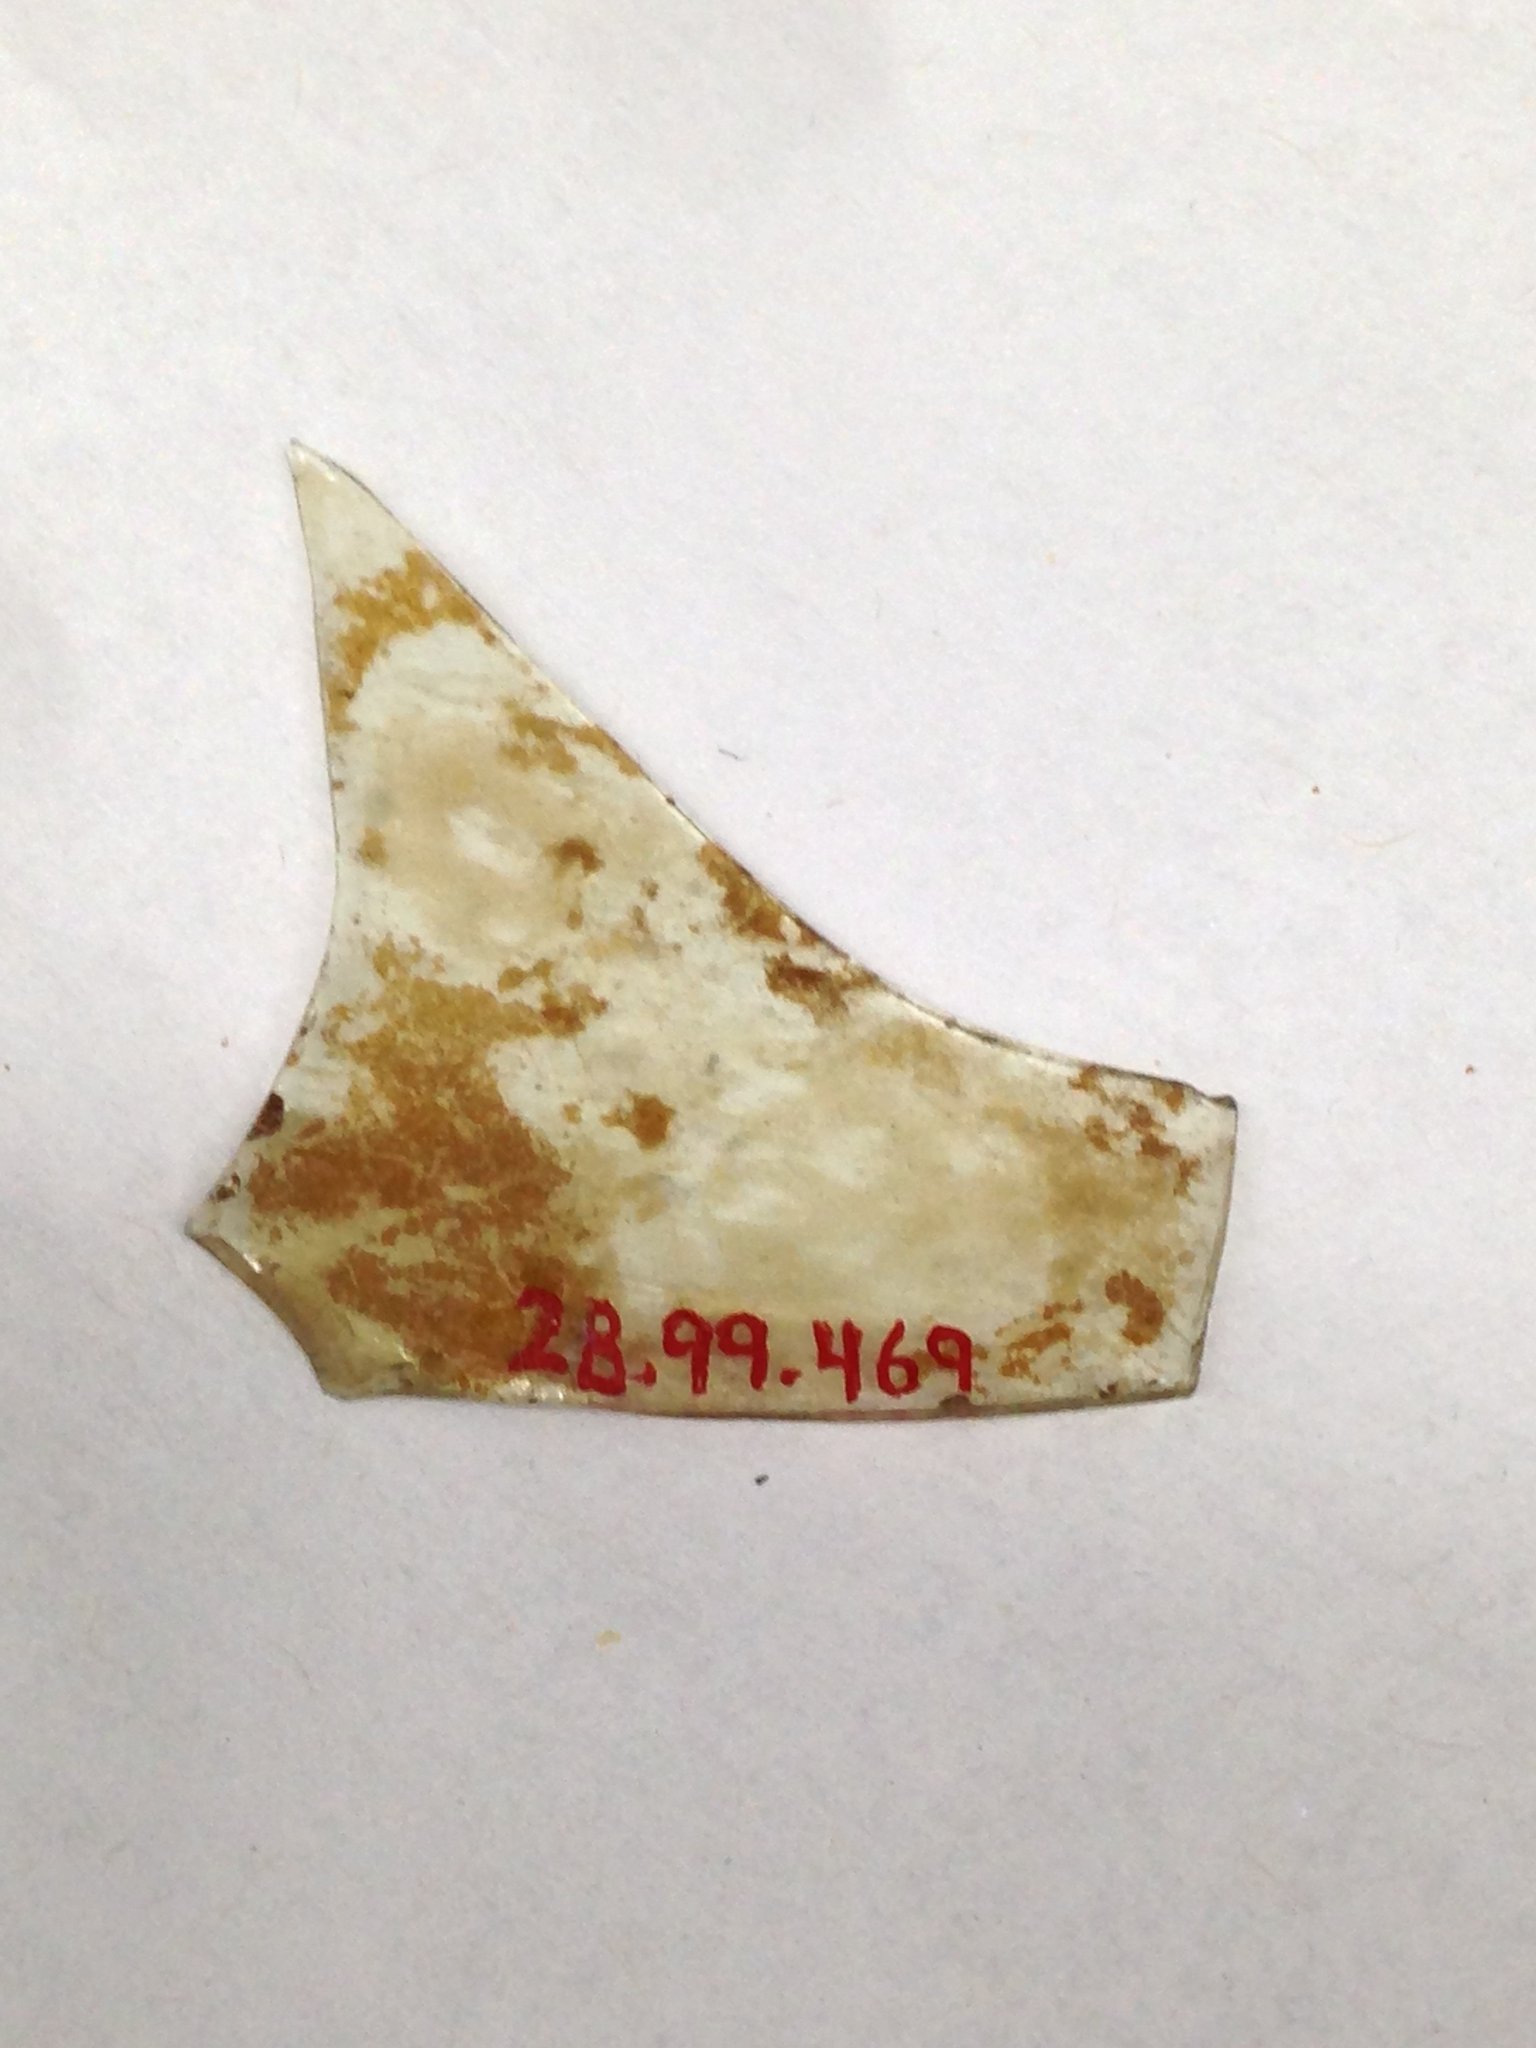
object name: fragment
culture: european or middle eastern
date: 1150-1250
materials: ceramic, glass